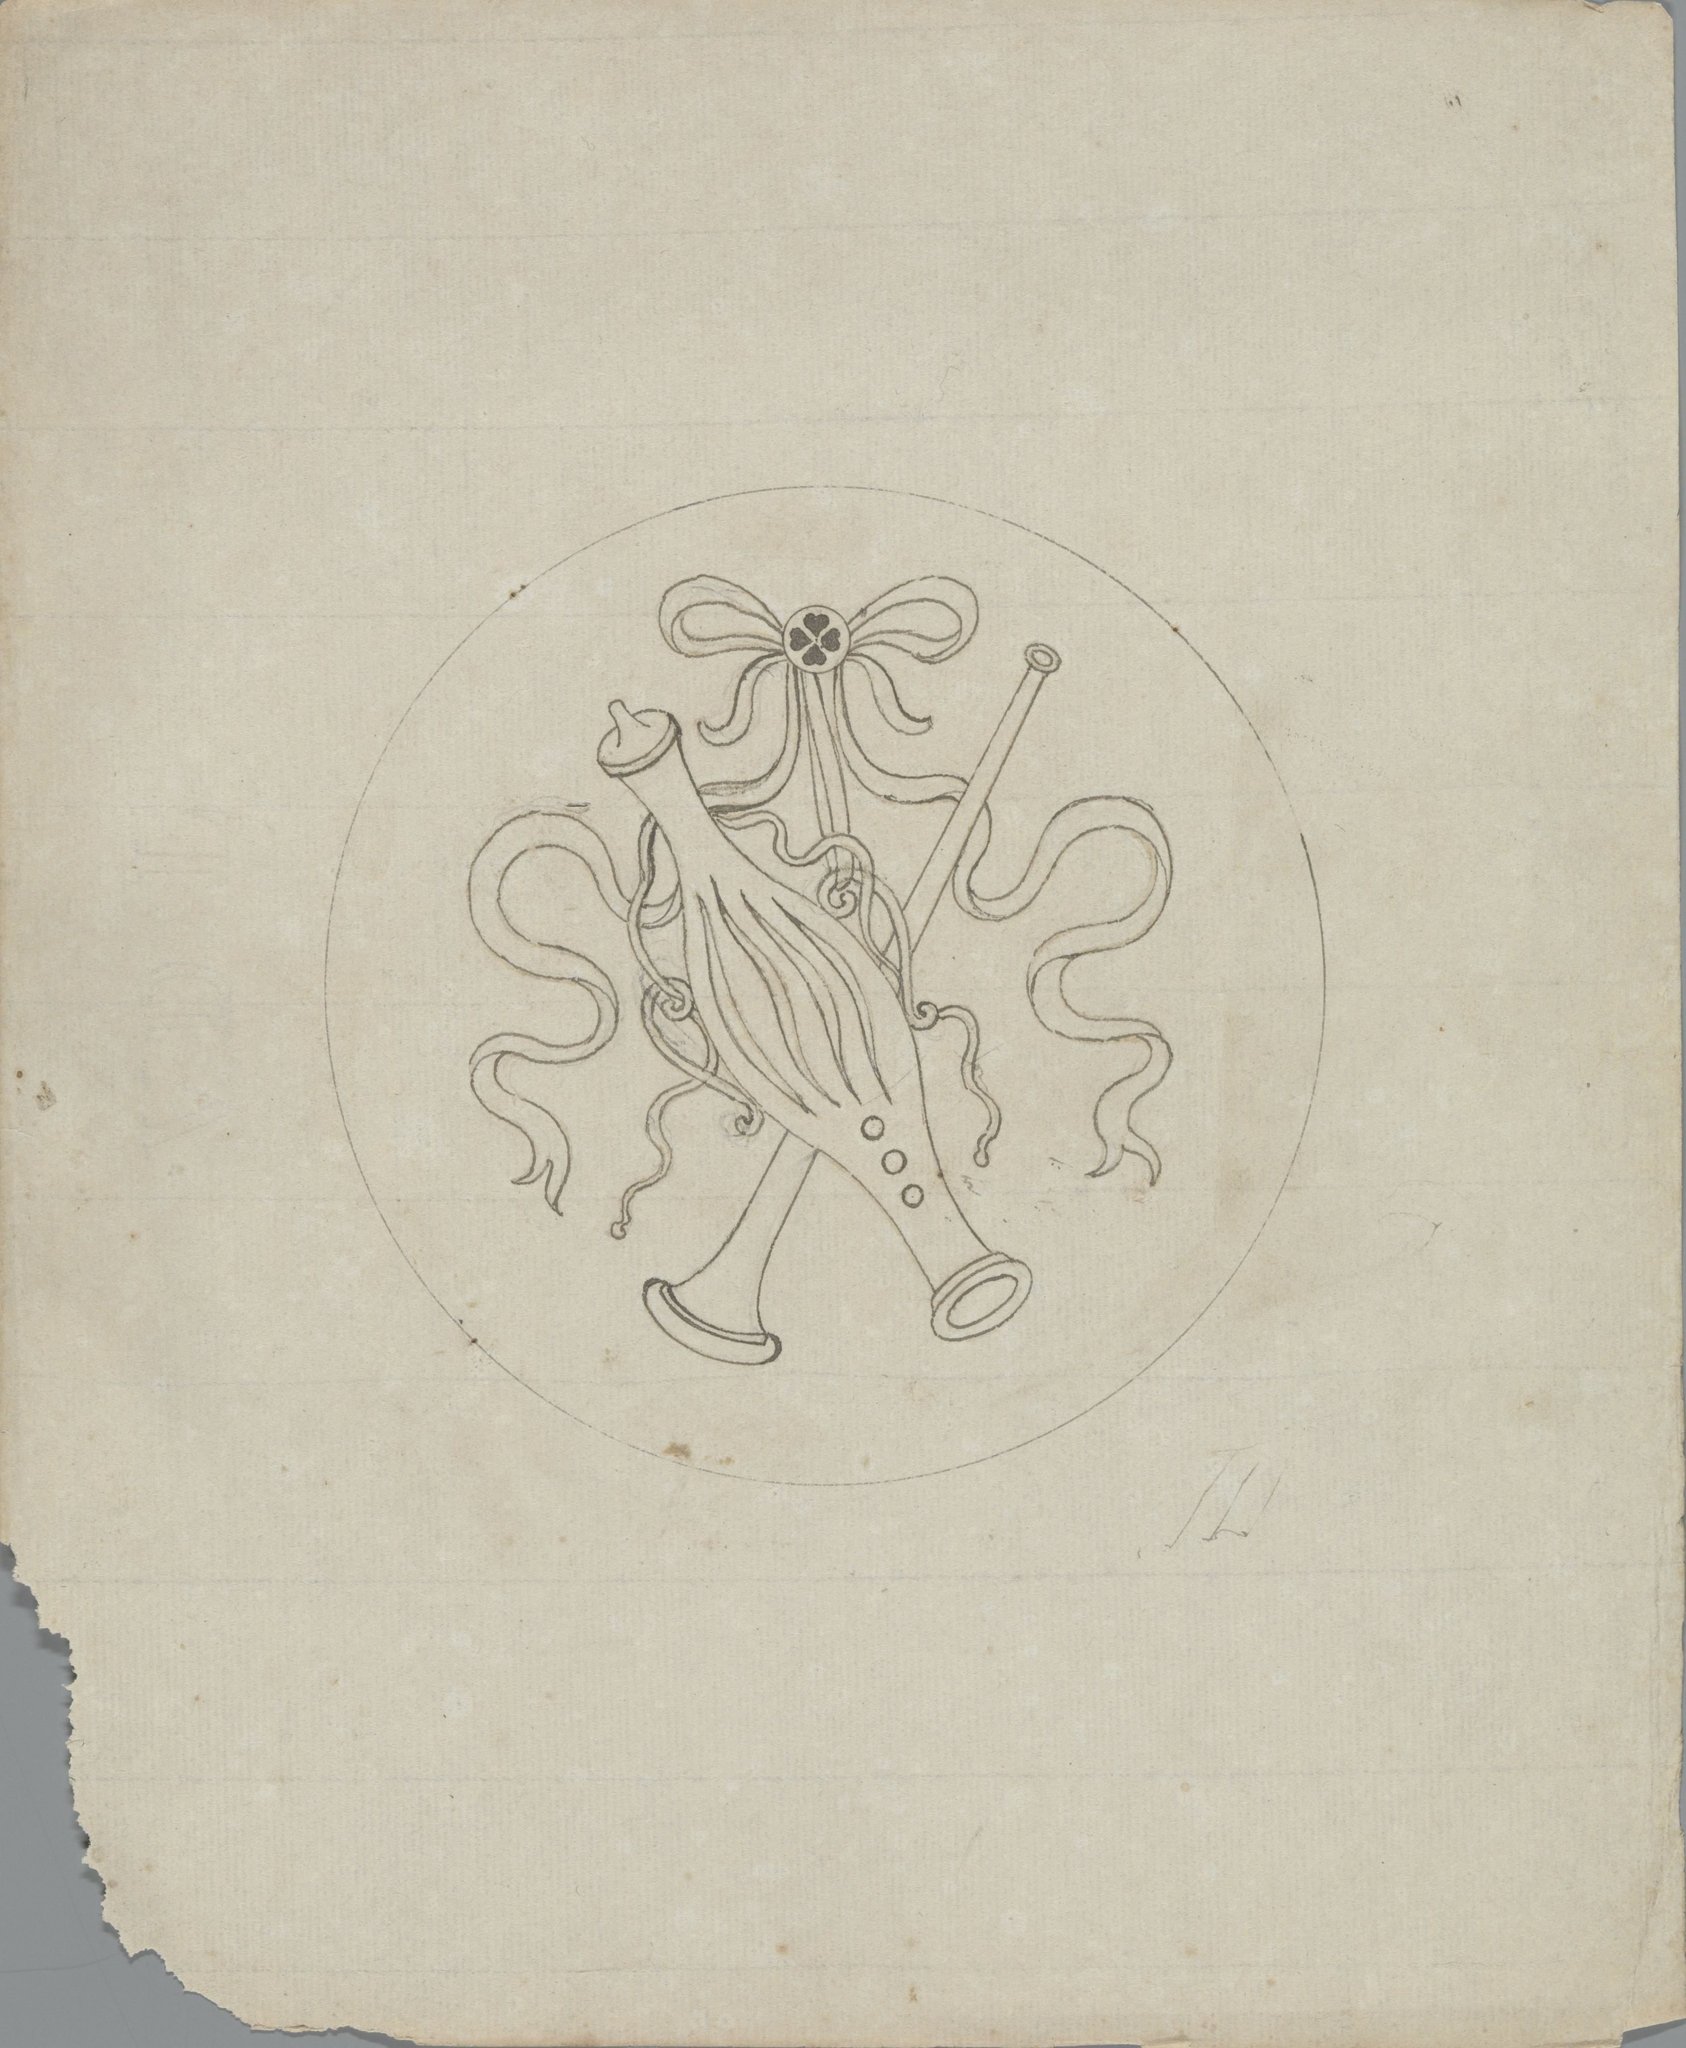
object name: design drawing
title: Ontwerp voor marqueterie van aan linten opgehangen muziekinstrument(en) in rond medaillon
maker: pierre félix van doren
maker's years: 1797-1856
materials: graphite, ink, paper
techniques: pen in black ink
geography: brussels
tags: trophy, i.e.: decorative arrangement of symbolic or typical objects ~ ornament, flute, aulos, tibia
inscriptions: inscription, watermark: ‘VDL’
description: Een van 103 ontwerpen voor marqueterie van aan linten opgehangen muziekinstrumenten in ronde medaillons, bestemd voor de set stoelen gemaakt door Van Doren voor de grote zaal van het Paleis van de Prins van Oranje in Brussel in 1828.